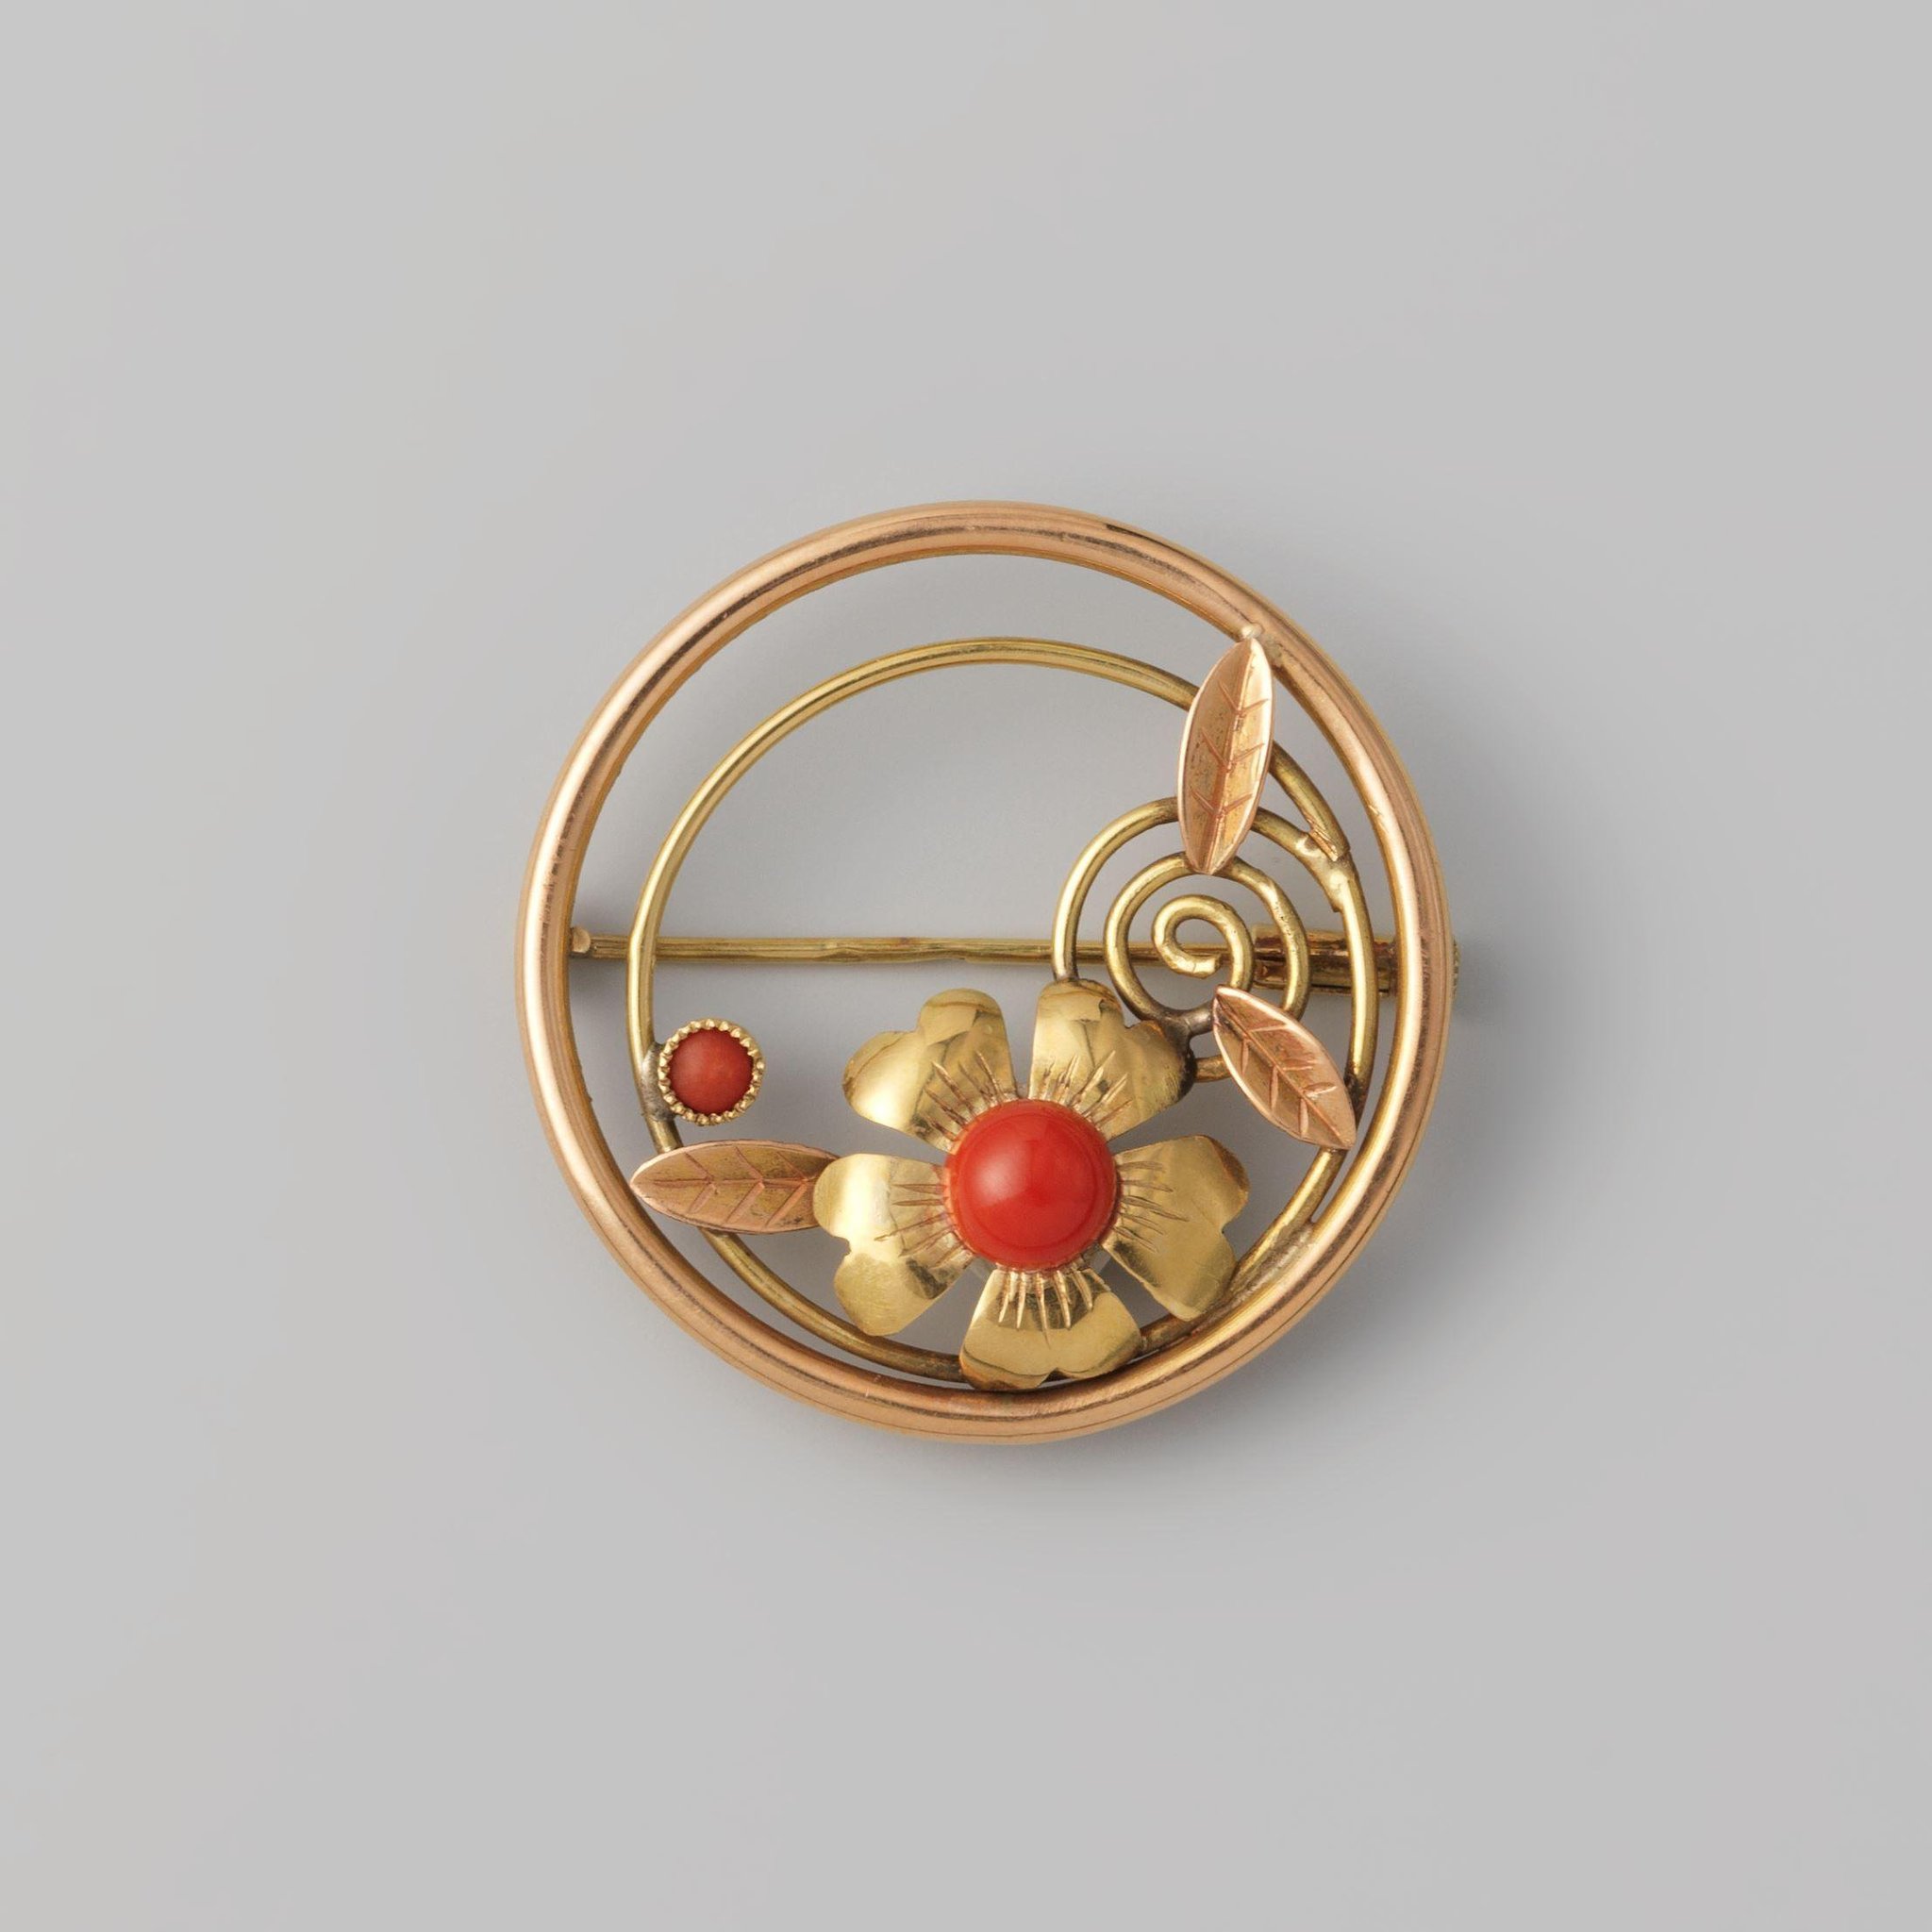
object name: brooch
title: Broche van gouddraad met bloem met hart van bloedkoraal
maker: carel theulings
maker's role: juwelier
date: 1940-1950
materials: gold thread, coral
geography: den bosch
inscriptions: alloy mark: ‘(oud) eikenblad’, maker's mark: ‘CT4’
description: Ronde broche van gouddraad in twee kleuren met bloem met hart van bloedkoraal voorzien van een kanonsluiting. In de broche zijn twee bloedkoralen verwerkt.